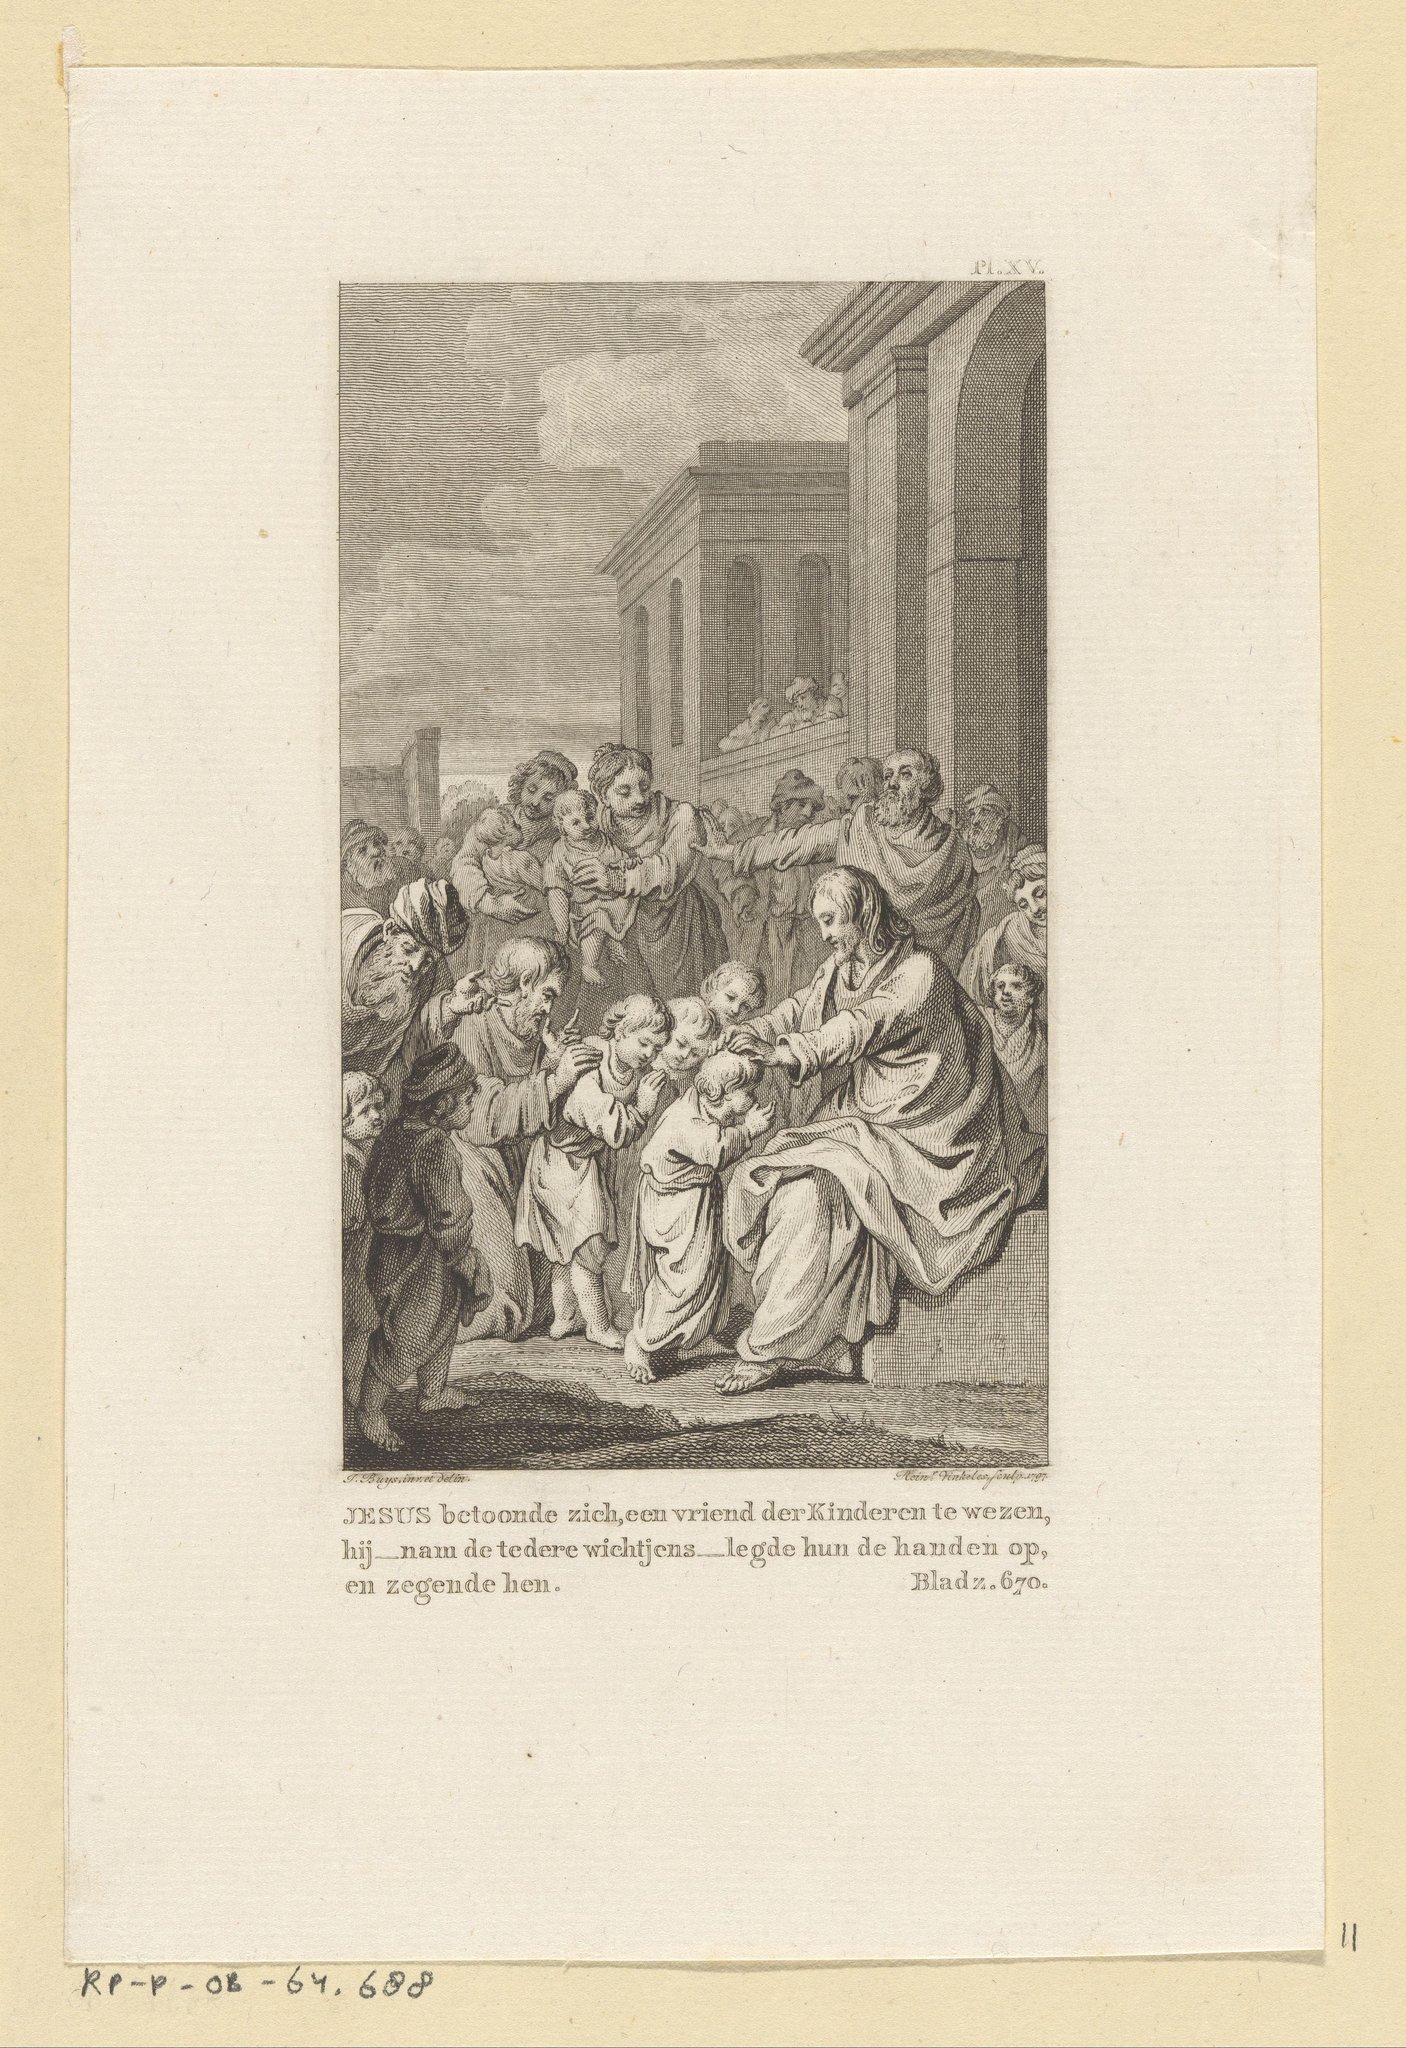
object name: print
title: Jesus betoonde zich, een vriend der Kinderen te wezen, hij nam de tedere wichtjens legde hun de handen op, en zegende hen.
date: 1797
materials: paper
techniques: engraving, etching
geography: amsterdam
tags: christ blessing children brought by their mothers, usually with some disciples disapprovingly looking on (matthew 19:13-15; mark 10:13-16; luke 18:15-17)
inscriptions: collector's mark: Lugt 240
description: Voor een tempel proberen de apostelen kinderen weg te houden van Christus. Christus laat de kinderen juist bij hem komen en zegent ze (Matteüs 19:13-15).